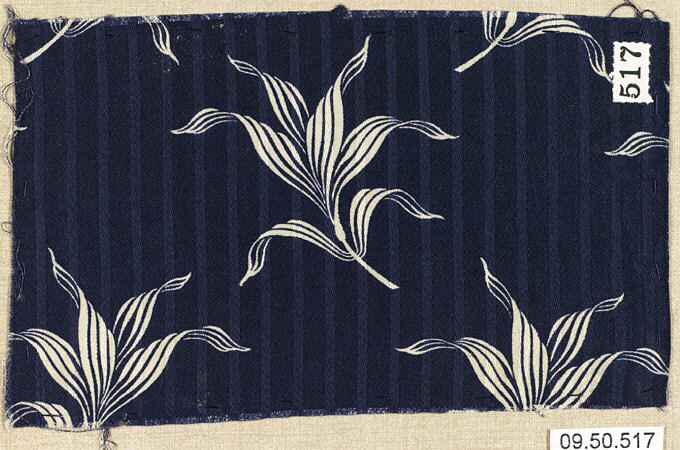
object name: piece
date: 1801-1900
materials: cotton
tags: leaves